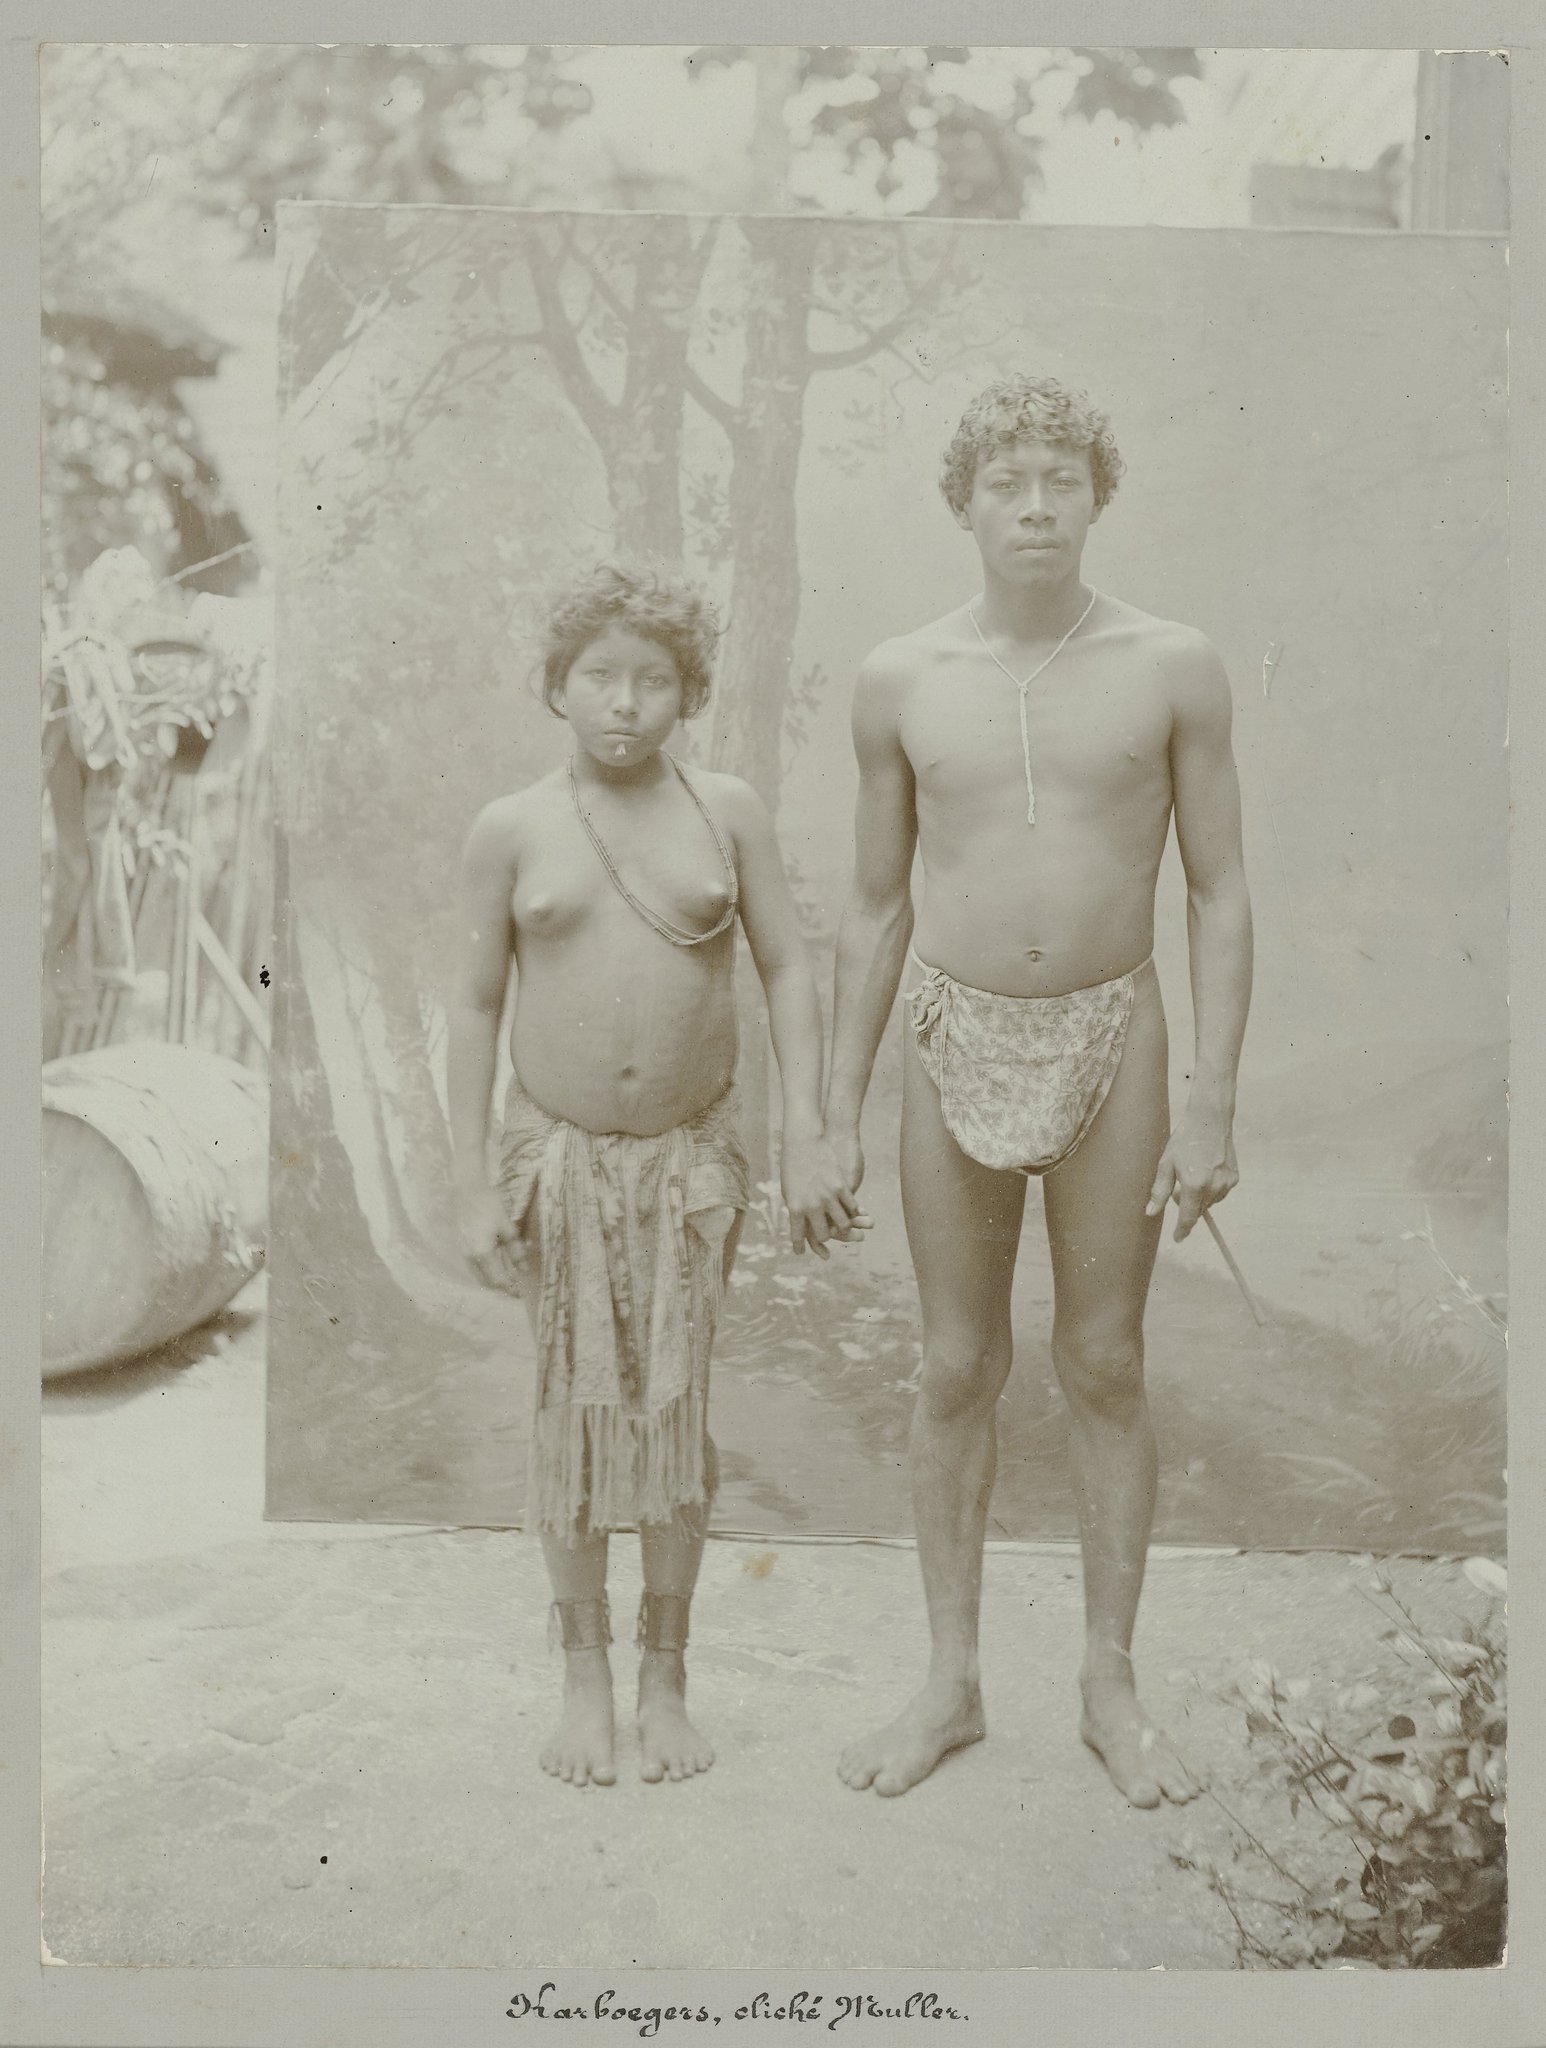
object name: photograph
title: Portret van een jong bruidspaar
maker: julius muller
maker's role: official, politician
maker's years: 1846-1902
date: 1885-1895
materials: photographic support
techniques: collodion silver print, gelatin silver print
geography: suriname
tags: indigenous peoples of south america, suriname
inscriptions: inscription: ‘Karboegers, cliché Muller.’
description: Portret van een jong bruidspaar, in het onderschrift aangeduid als 'Karboegers' (Carboegers), staande voor een doek met geschilderd fantasiedecor. 'Karboegers' was een koloniale term voor personen van gemengde afkomst, in dit geval ¼ wit en ¾ zwart. Opname in de tuin van de fotograaf te Paramaribo. Onderdeel van het fotoalbum van de familie Doijer, Souvenir de Voyage (deel 3), in en rond de plantage Ma Retraite in Suriname in de jaren 1906-1913.